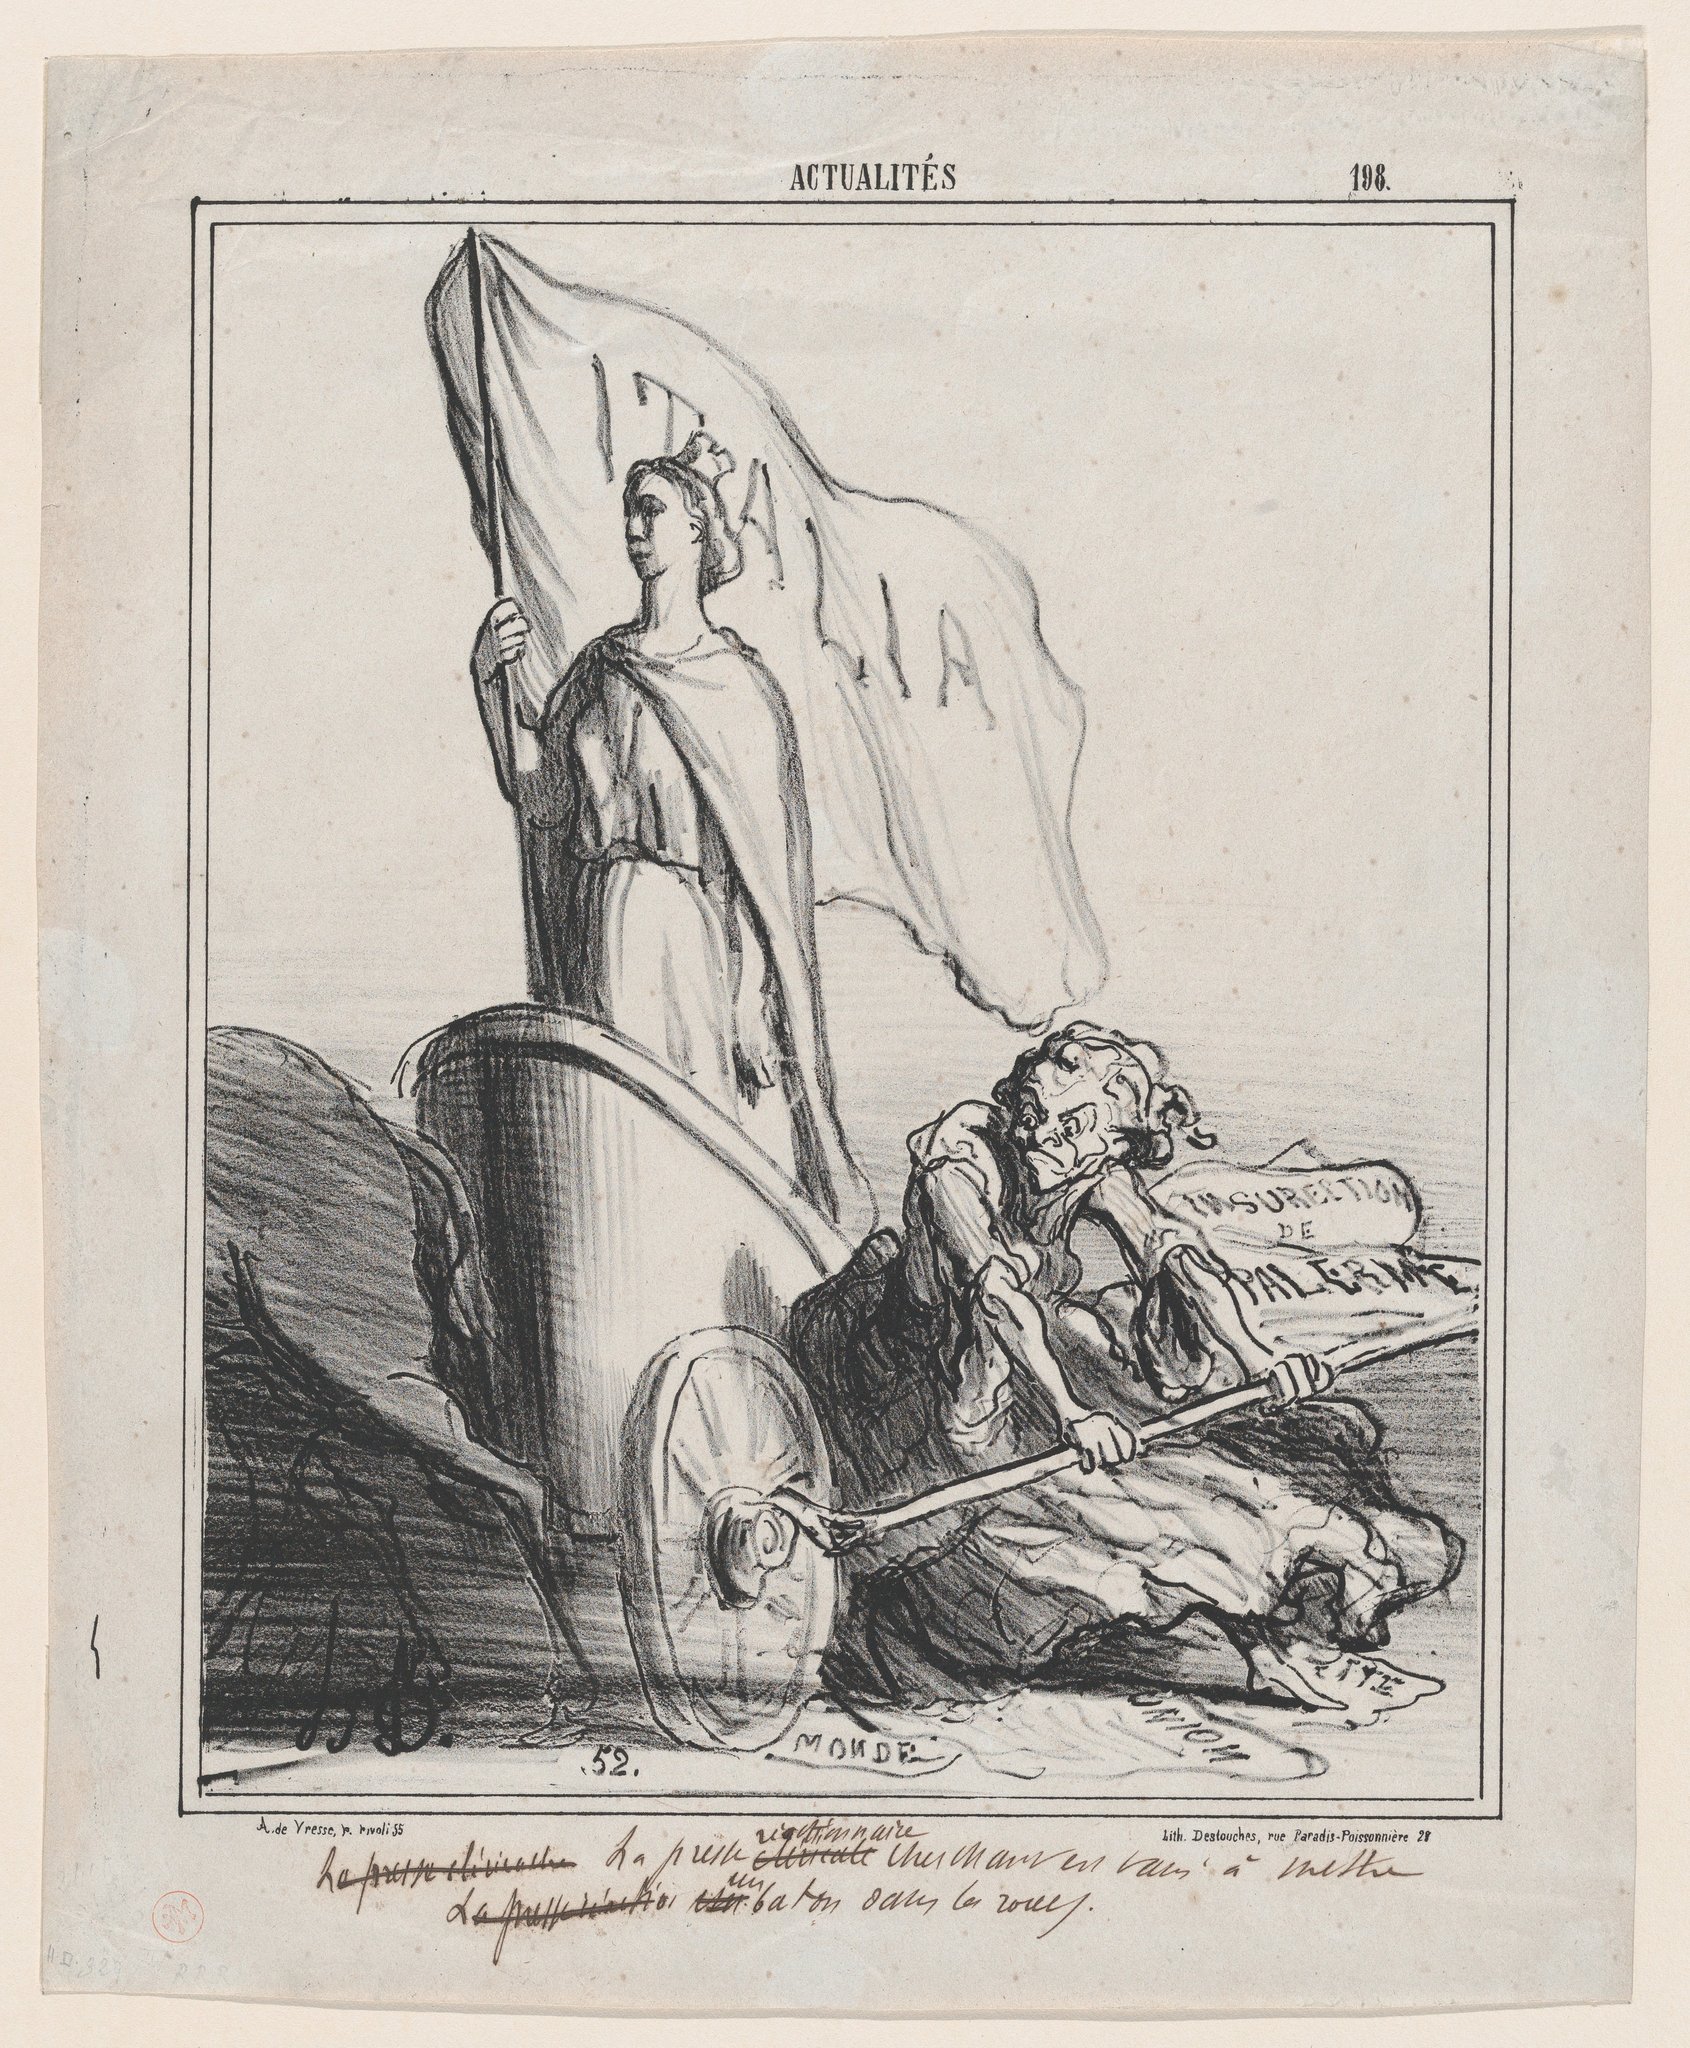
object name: print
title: The reactionary press, trying in vain to jam the wheels, from 'News of the day,' published in "Le Charivari"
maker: honoré daumier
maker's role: artist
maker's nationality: french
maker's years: 1808-1879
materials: ink, paper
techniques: lithograph, pen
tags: men,women,flags